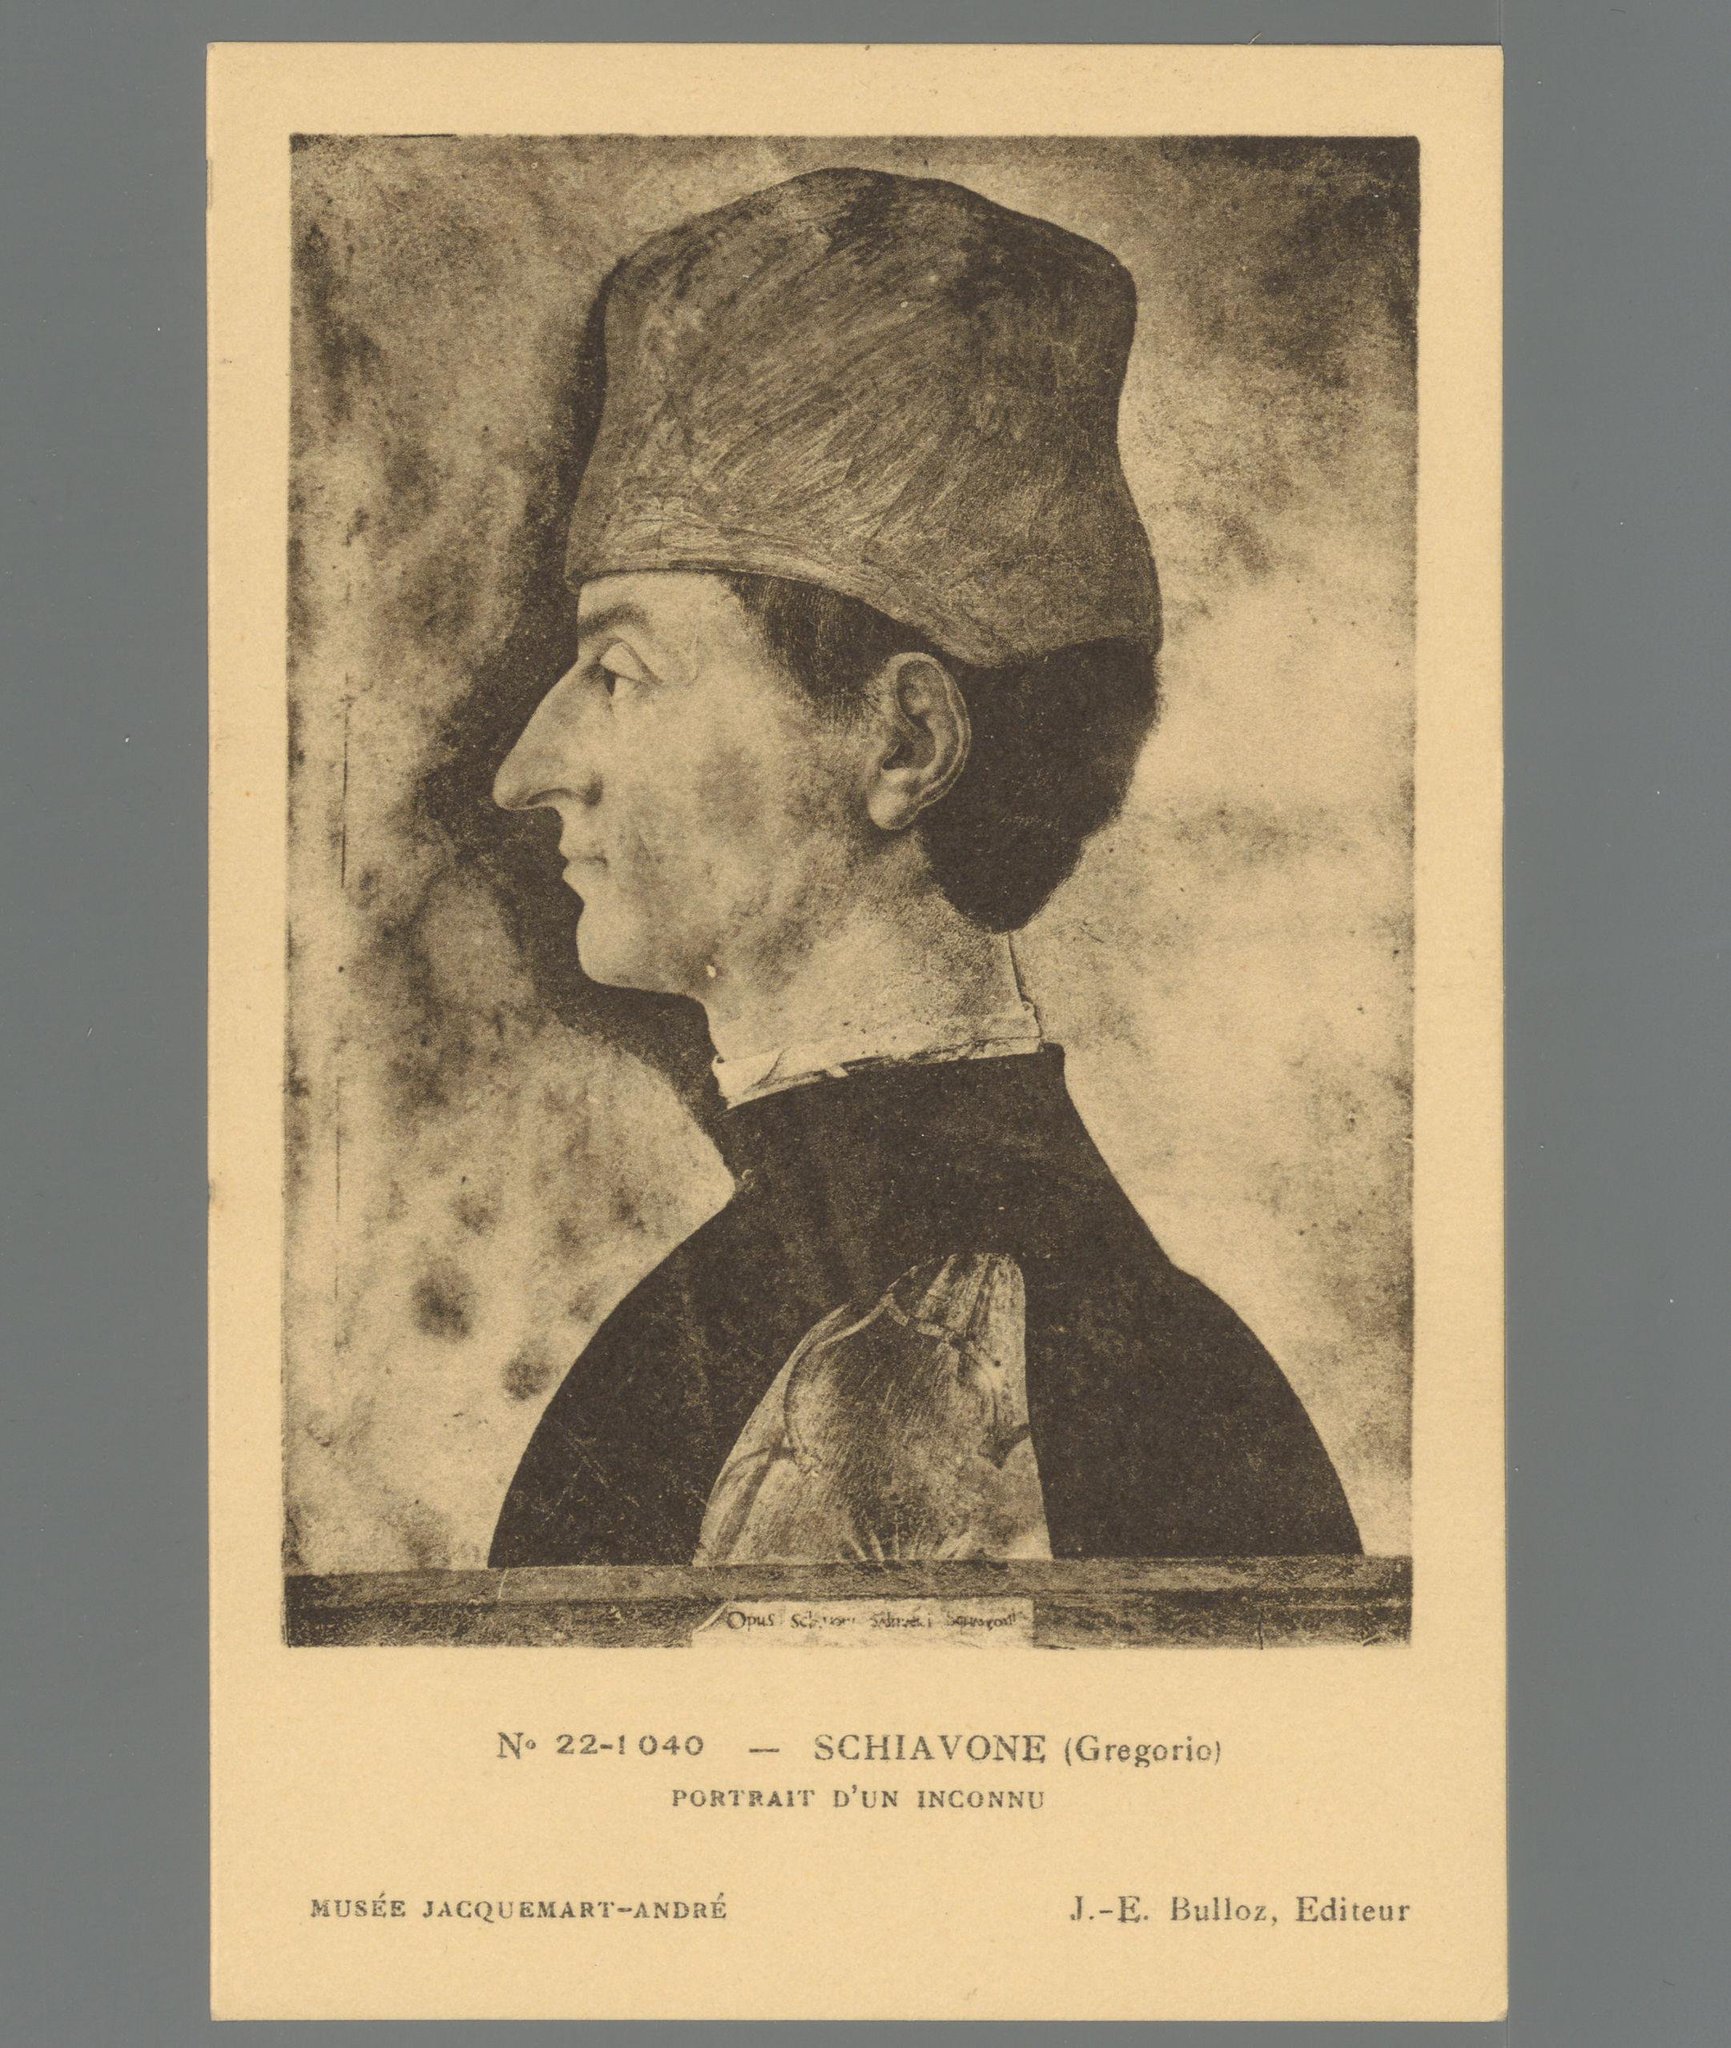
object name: photomechanical print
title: Schiavone (Gregorio). Portrait d'un inconnu. Musée Jacquemart-André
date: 1903-1930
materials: cardboard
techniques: photograph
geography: paris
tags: permanent exhibition, museum, picture, painting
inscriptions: collector's mark: ‘AFE v S’